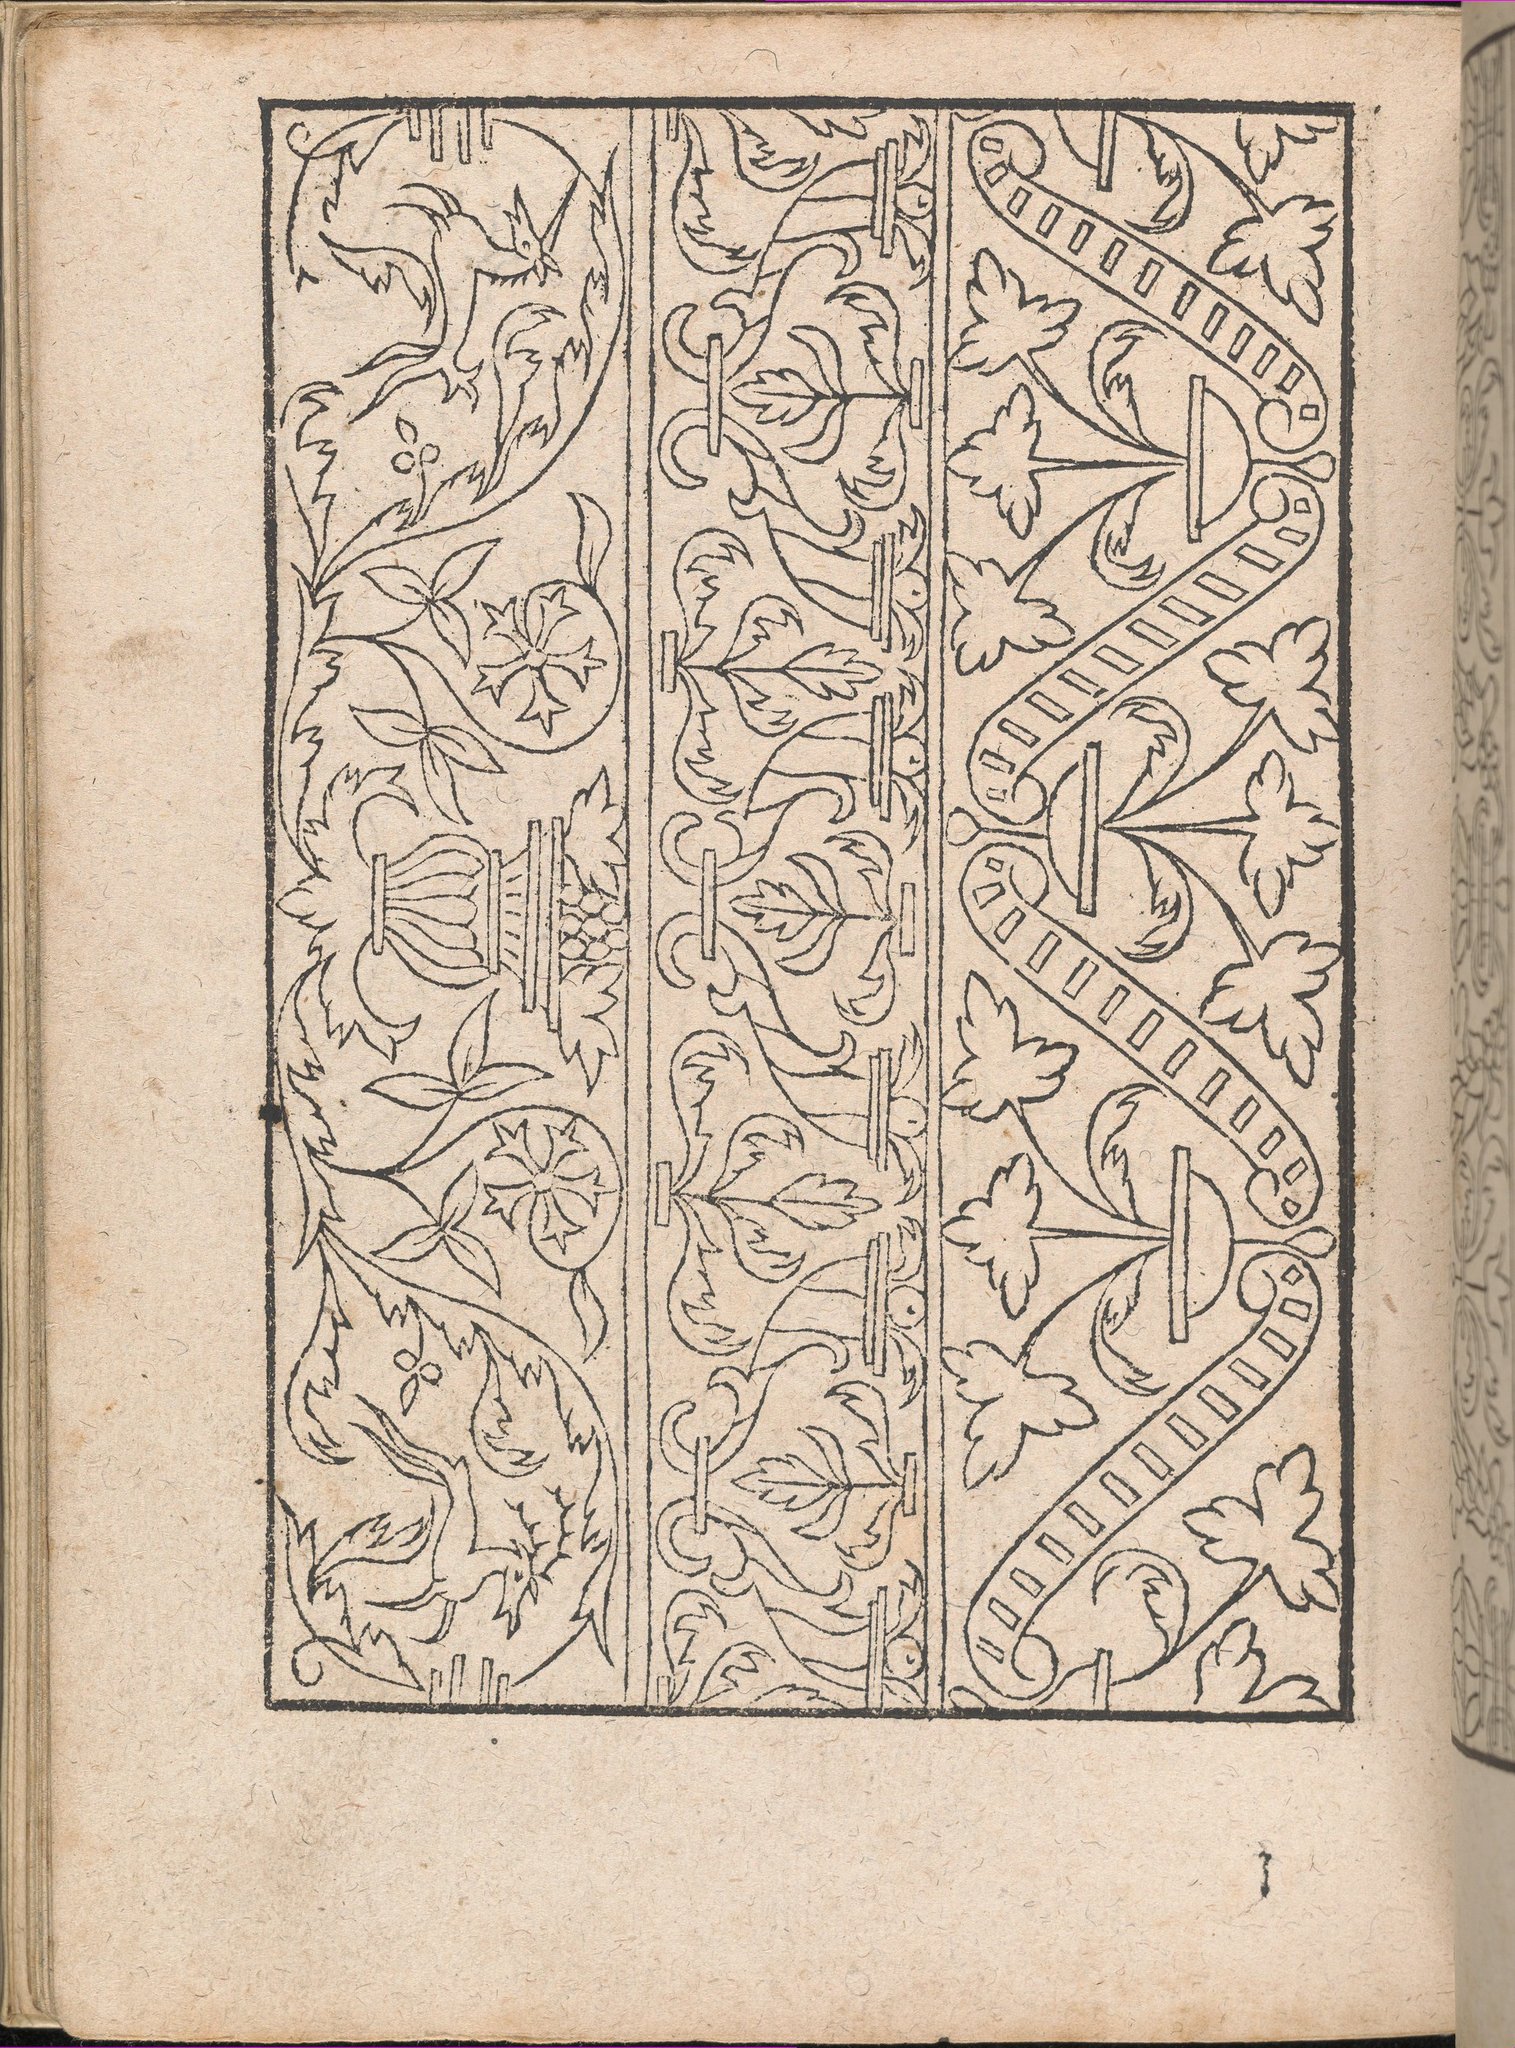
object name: book print ornament architecture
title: New Modelbüch allen Nägerin u. Sydenstickern (Page 20v)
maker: hans hoffman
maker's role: designer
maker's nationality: german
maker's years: 1556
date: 1556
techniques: woodcut